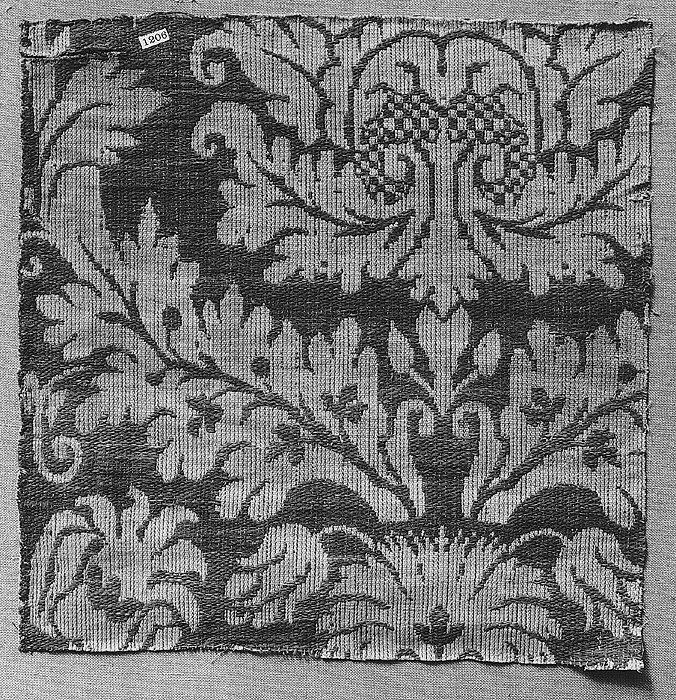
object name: piece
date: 1801-1900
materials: cotton, linen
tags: leaves